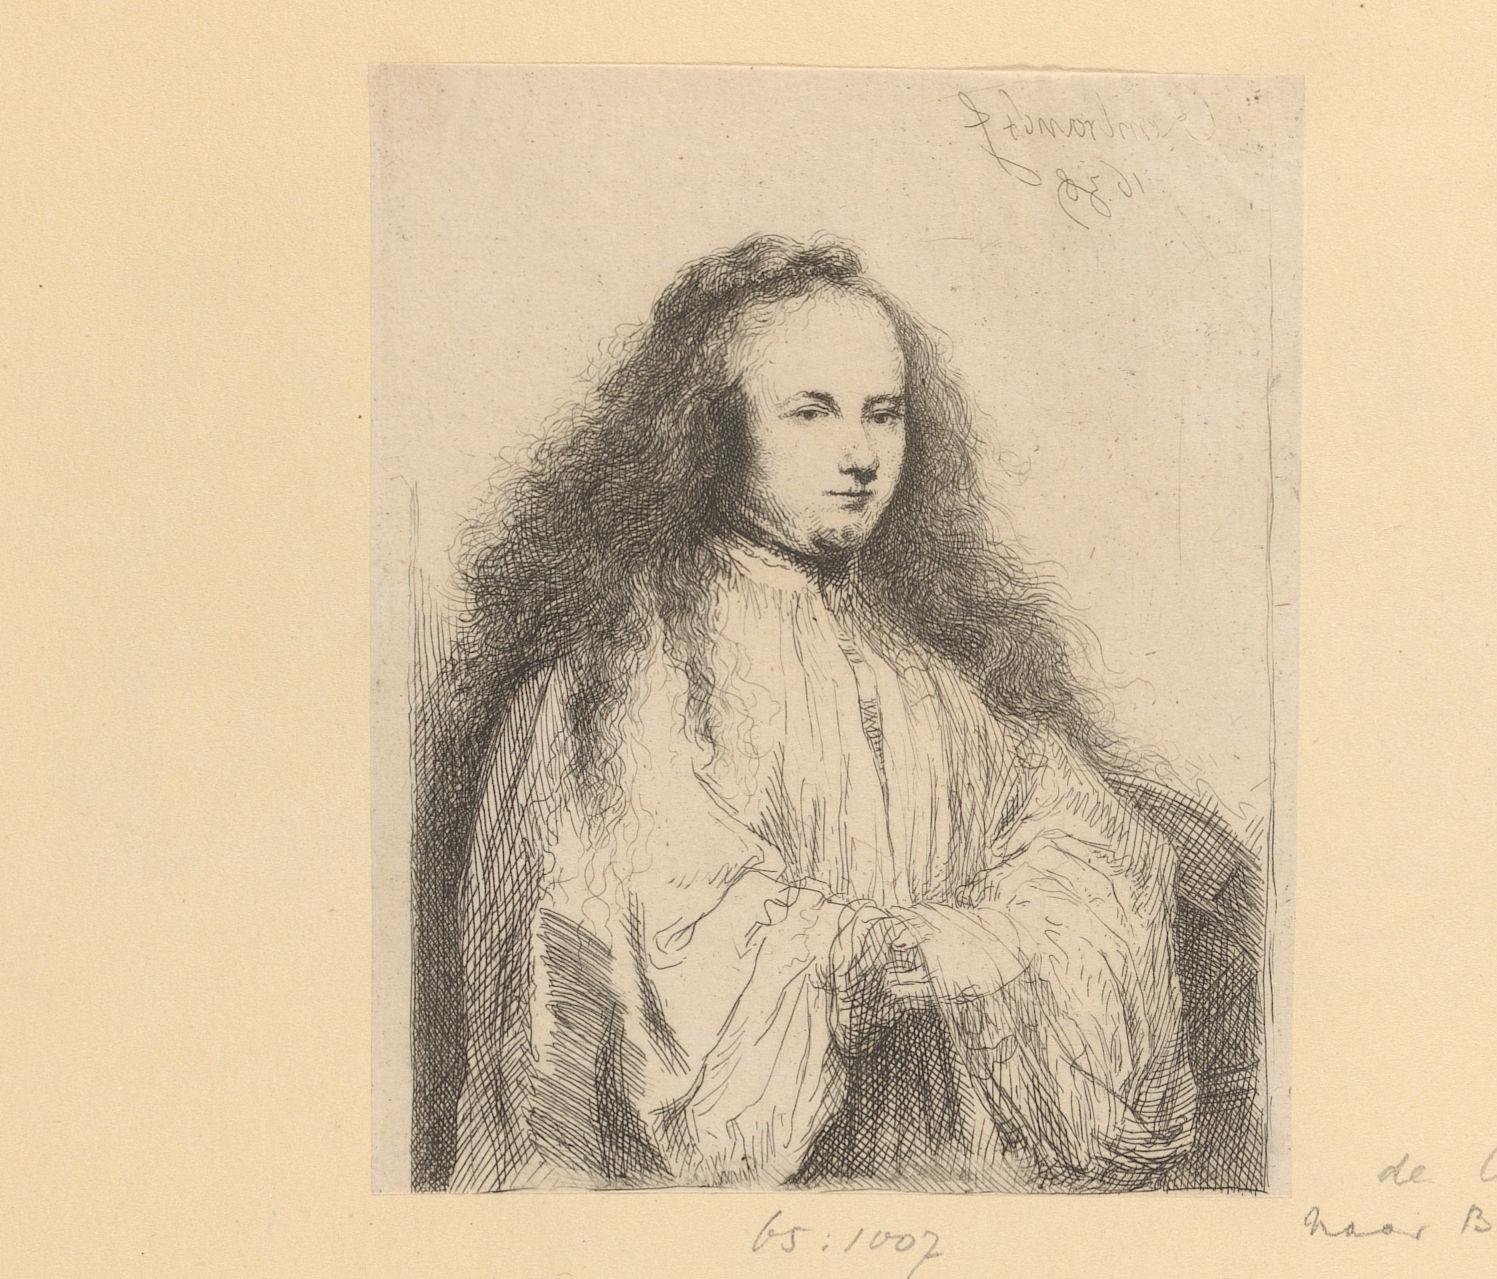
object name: album leaf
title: Kleine Joodse bruid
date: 1805-1844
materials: paper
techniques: etching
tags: bride (in wedding-dress)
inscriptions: signature and date (false): ‘Rembrandt f 1638’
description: Prent maakt mogelijk deel uit van een serie van 200 prenten. Deze serie is onder de titel 'A Collection of two hundred original etchings' voor het eerst uitgegeven door J.M. Greery in 1816.